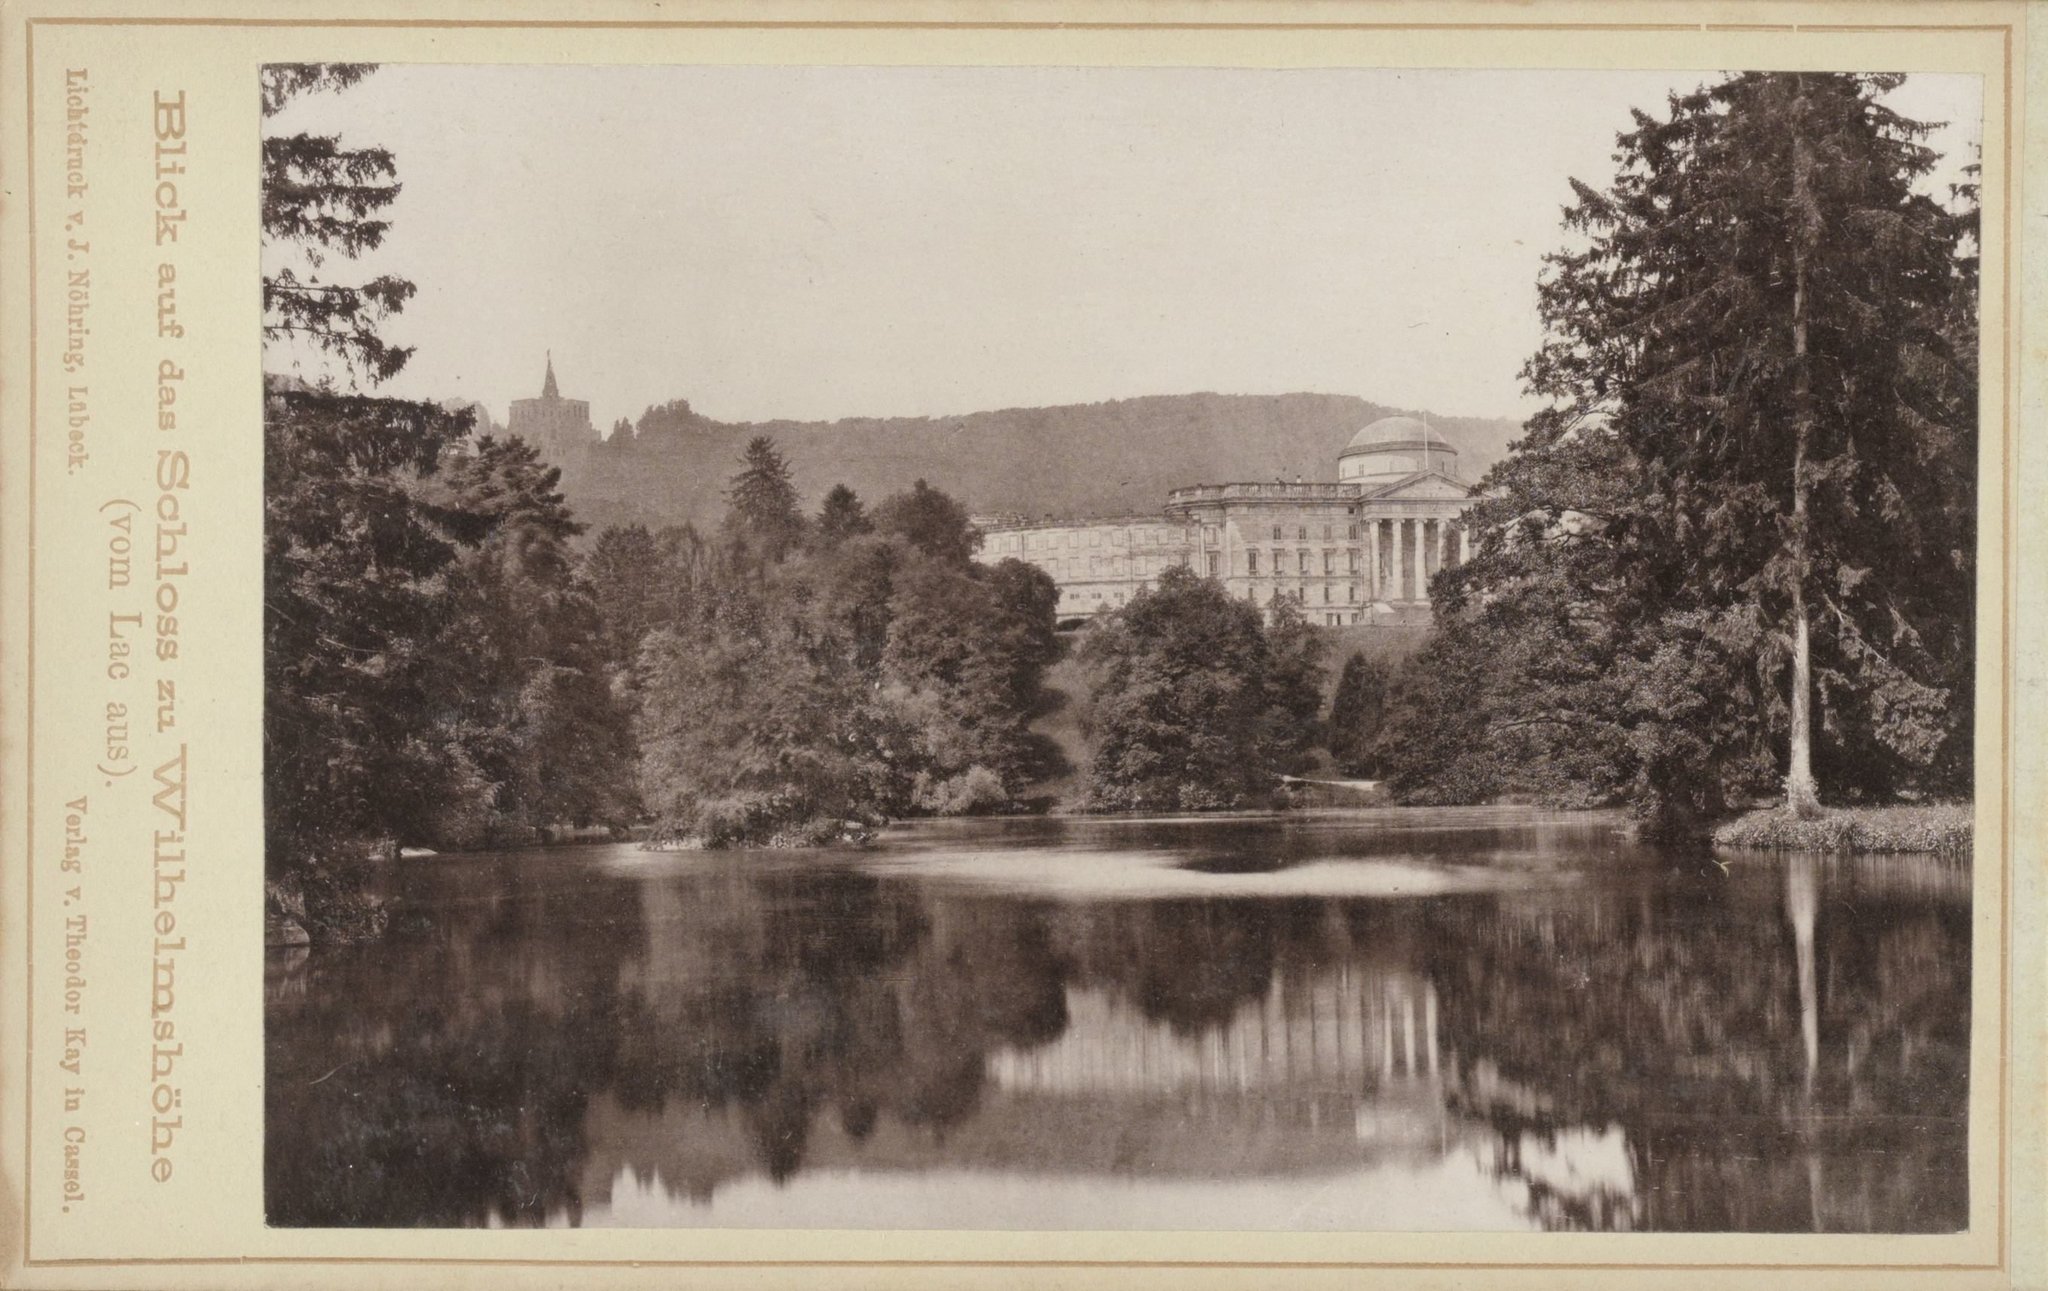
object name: photograph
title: Kasteel Wilhelmshöhe gezien over een meer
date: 1870-1890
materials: cardboard, paper, photographic support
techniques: photograph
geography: kassel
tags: castle, travelling; tourism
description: Onderdeel van Album met 38 foto's van een reis door de Harz.